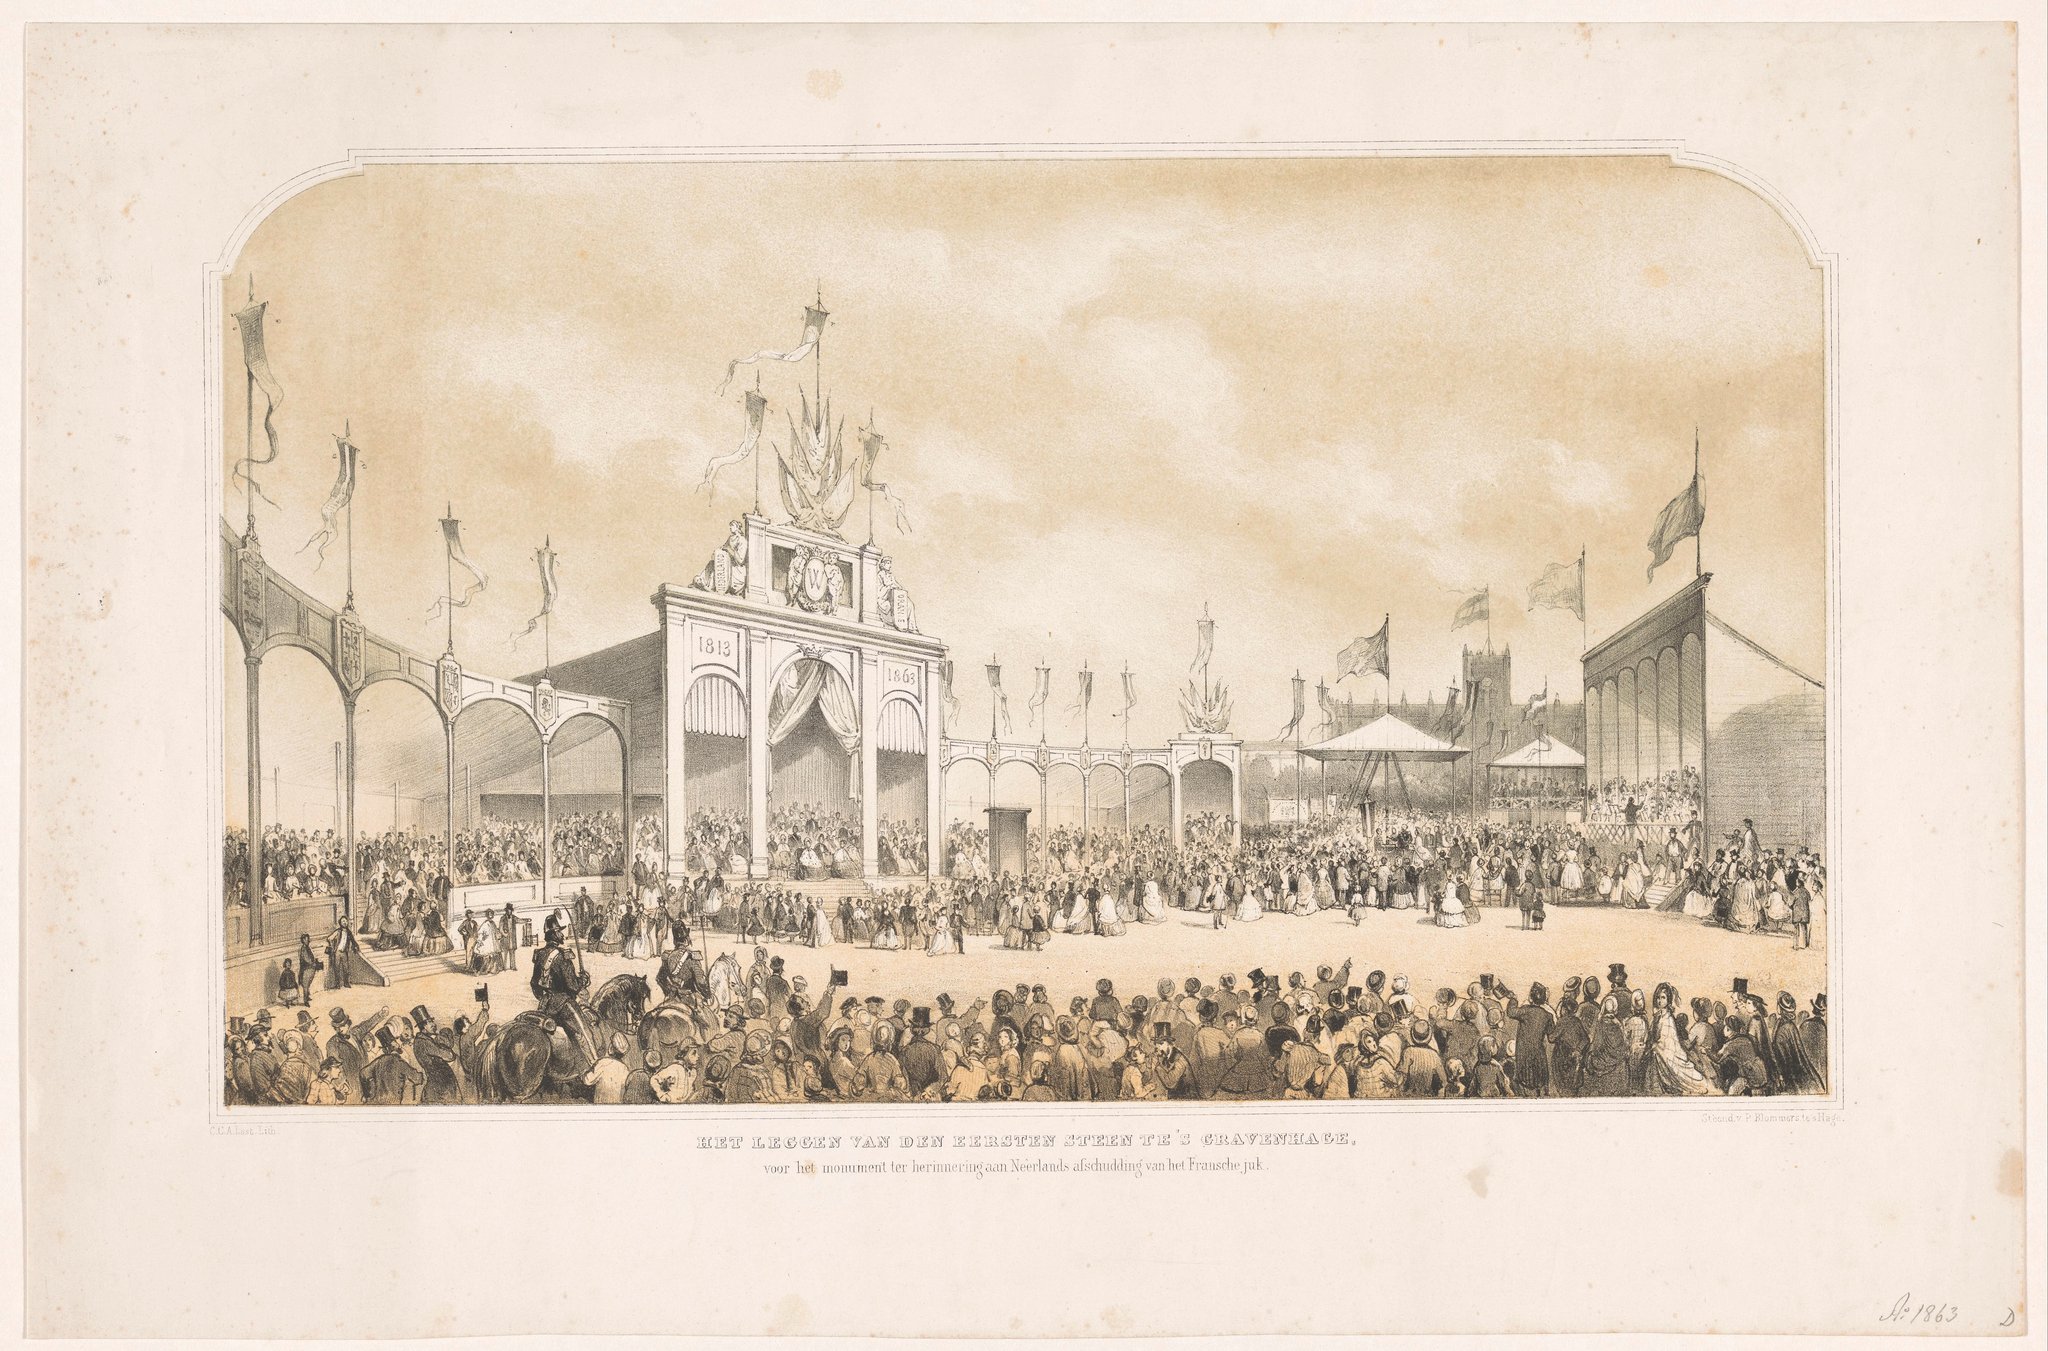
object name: print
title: Koning Willem III legt de eerste steen voor het monument ter herinnering aan de bevrijding van de Fransen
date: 1863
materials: paper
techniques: tone lithography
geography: the hague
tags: brussels, willem iii (koning der nederlanden), ceremonial laying of the foundations, laying the first stone, the hague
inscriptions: collector's mark: Lugt 2228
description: Een menigte heeft zich verzameld op een grote ronde tribune met daarop wapperende vaandels en de jaartallen 1813 en 1863. Links zit de Koninklijke familie en in het midden, onder een tent, legt Koning Willem III de steen. Rechts een tribune met een koor.